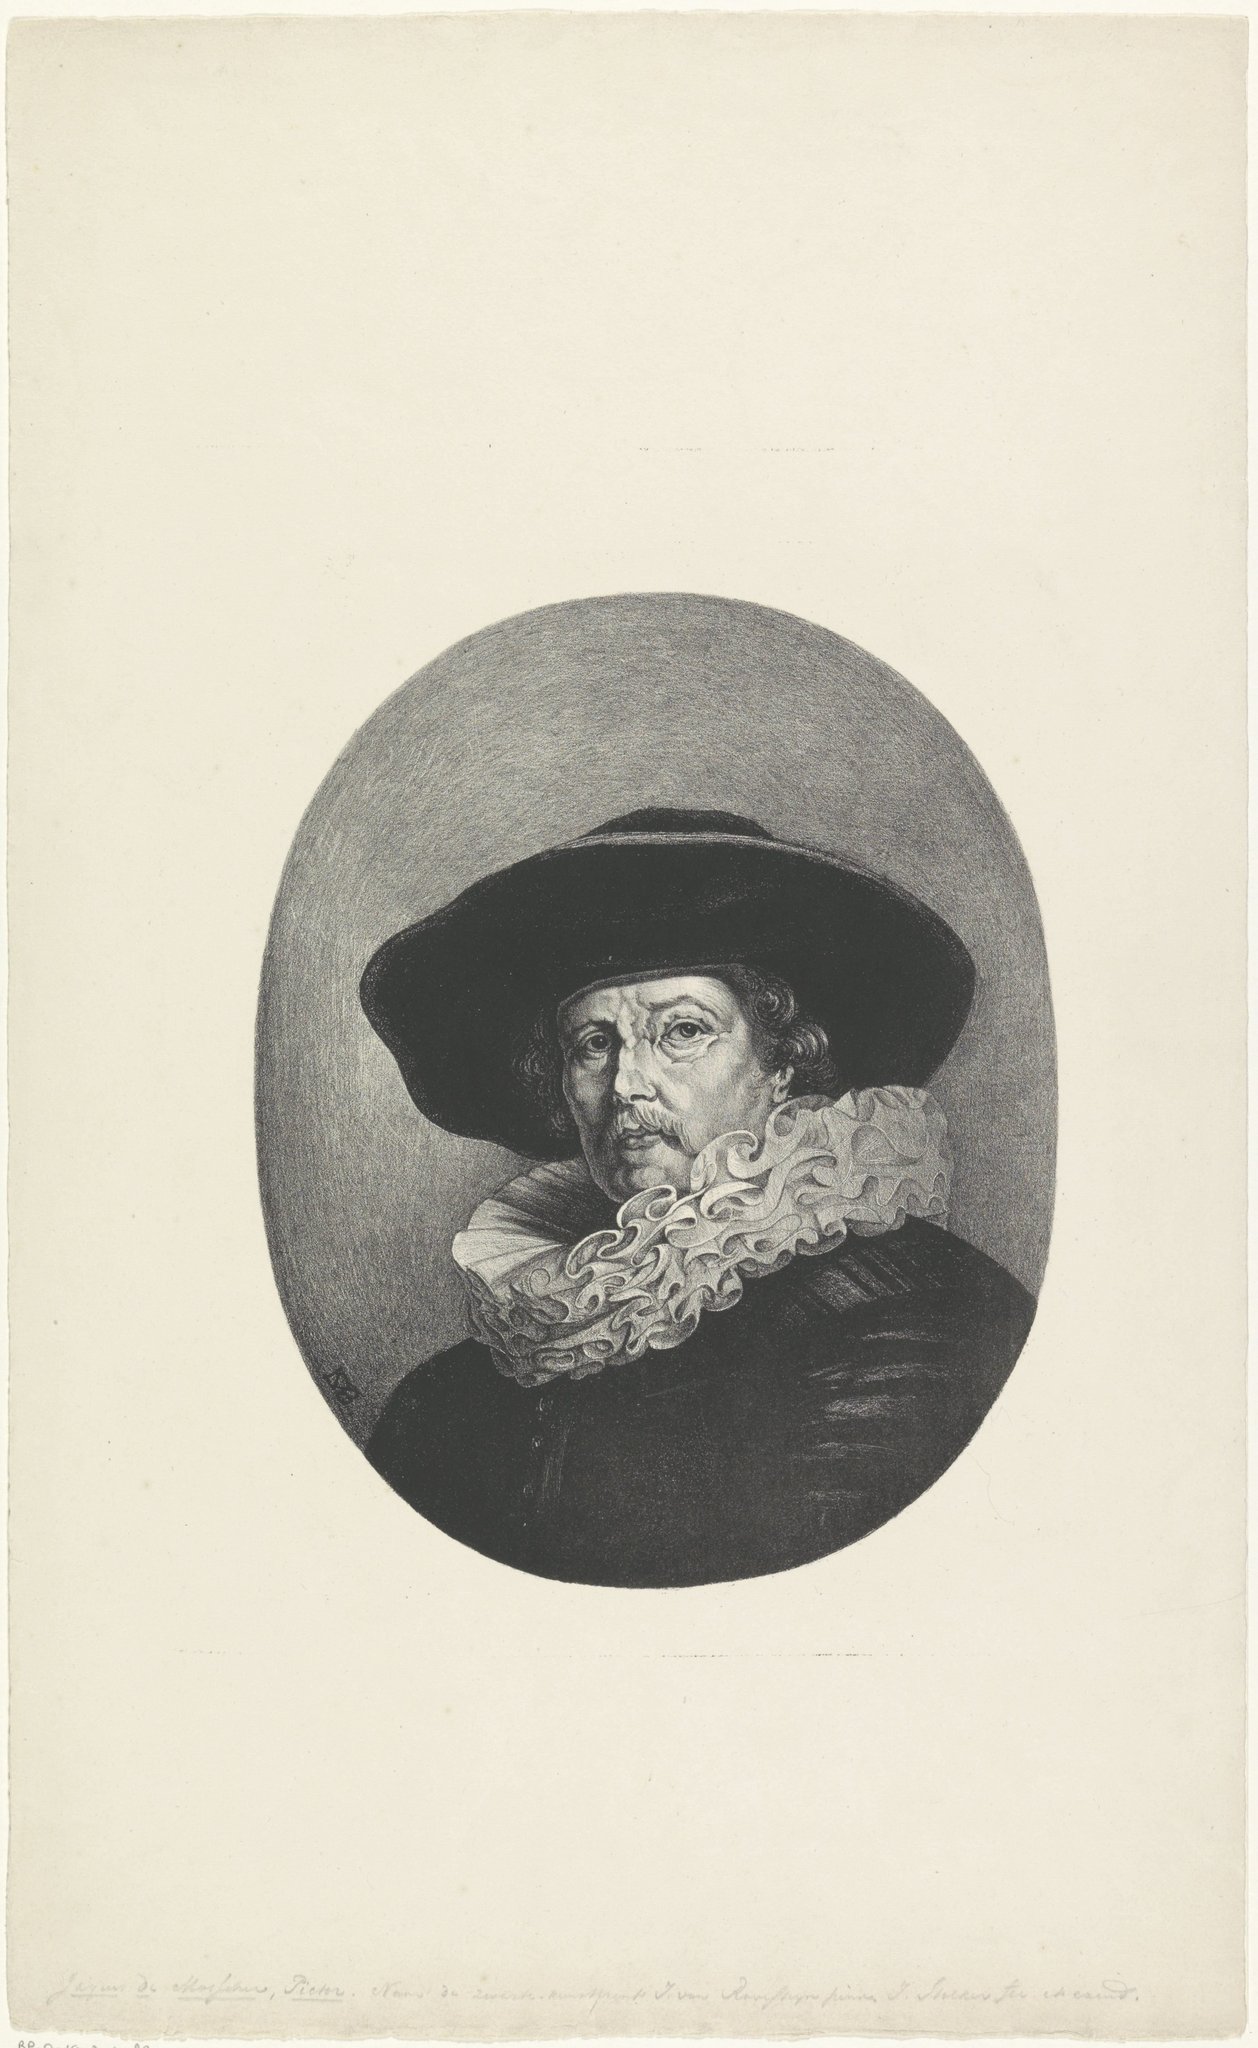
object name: print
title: Portret van de schilder Jacob van Mosscher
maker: jonkheer isaac lambertus cremer van den berch van heemstede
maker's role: print maker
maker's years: 1811-1879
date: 1821-1879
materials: paper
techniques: lithograph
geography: netherlands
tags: neck-gear ~ clothing (with name)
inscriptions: inscription: ‘Jaques de Mosscher, Pieter. Naar de zwarte kunstprent J. van Ravesteyn pinx J Stolker fec et exudit’, collector's mark: Lugt 2228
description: De geportretteerde is afgebeeld in een ovaal en draagt een hoed en een plooikraag.